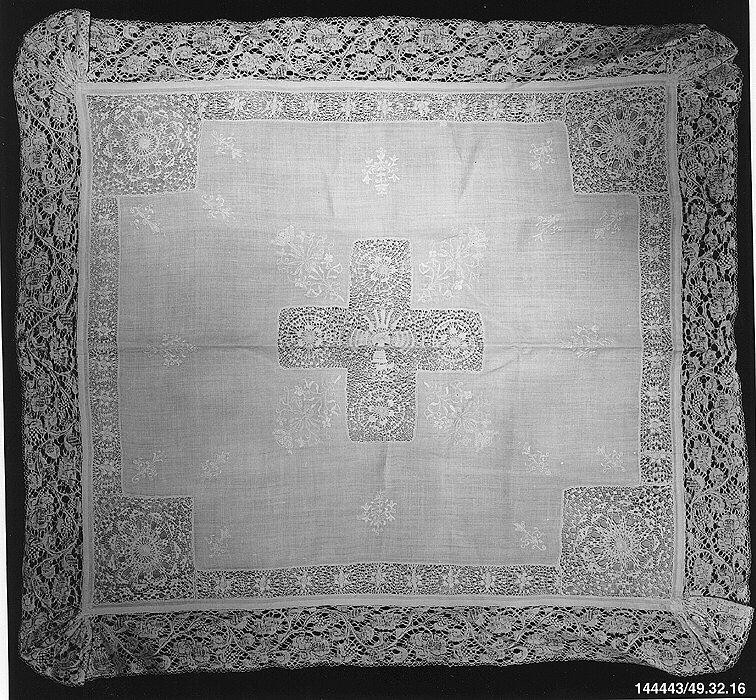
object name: cover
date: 1601-1633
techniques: embroidery